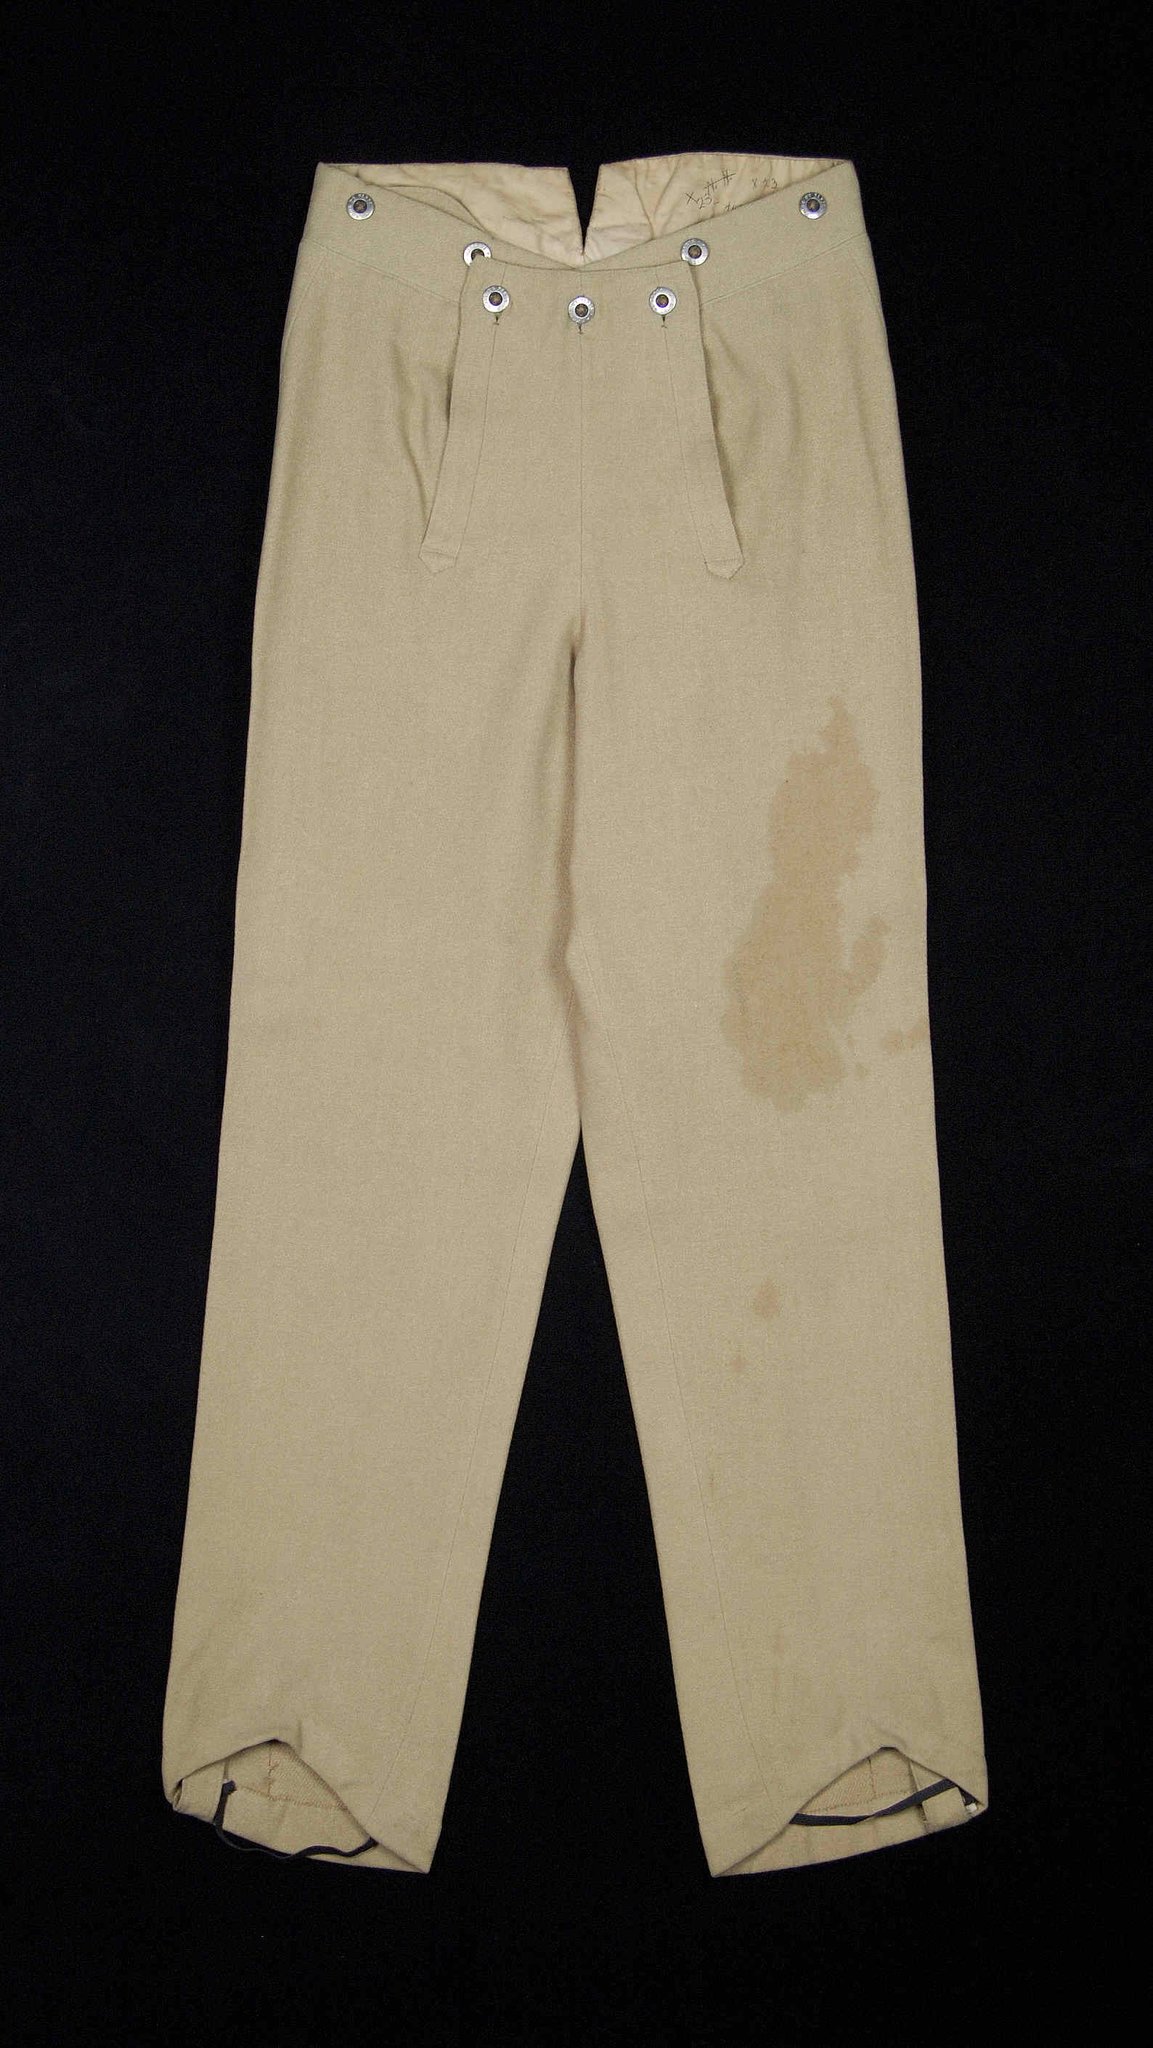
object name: trouser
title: Trousers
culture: american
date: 1850-1859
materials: wool